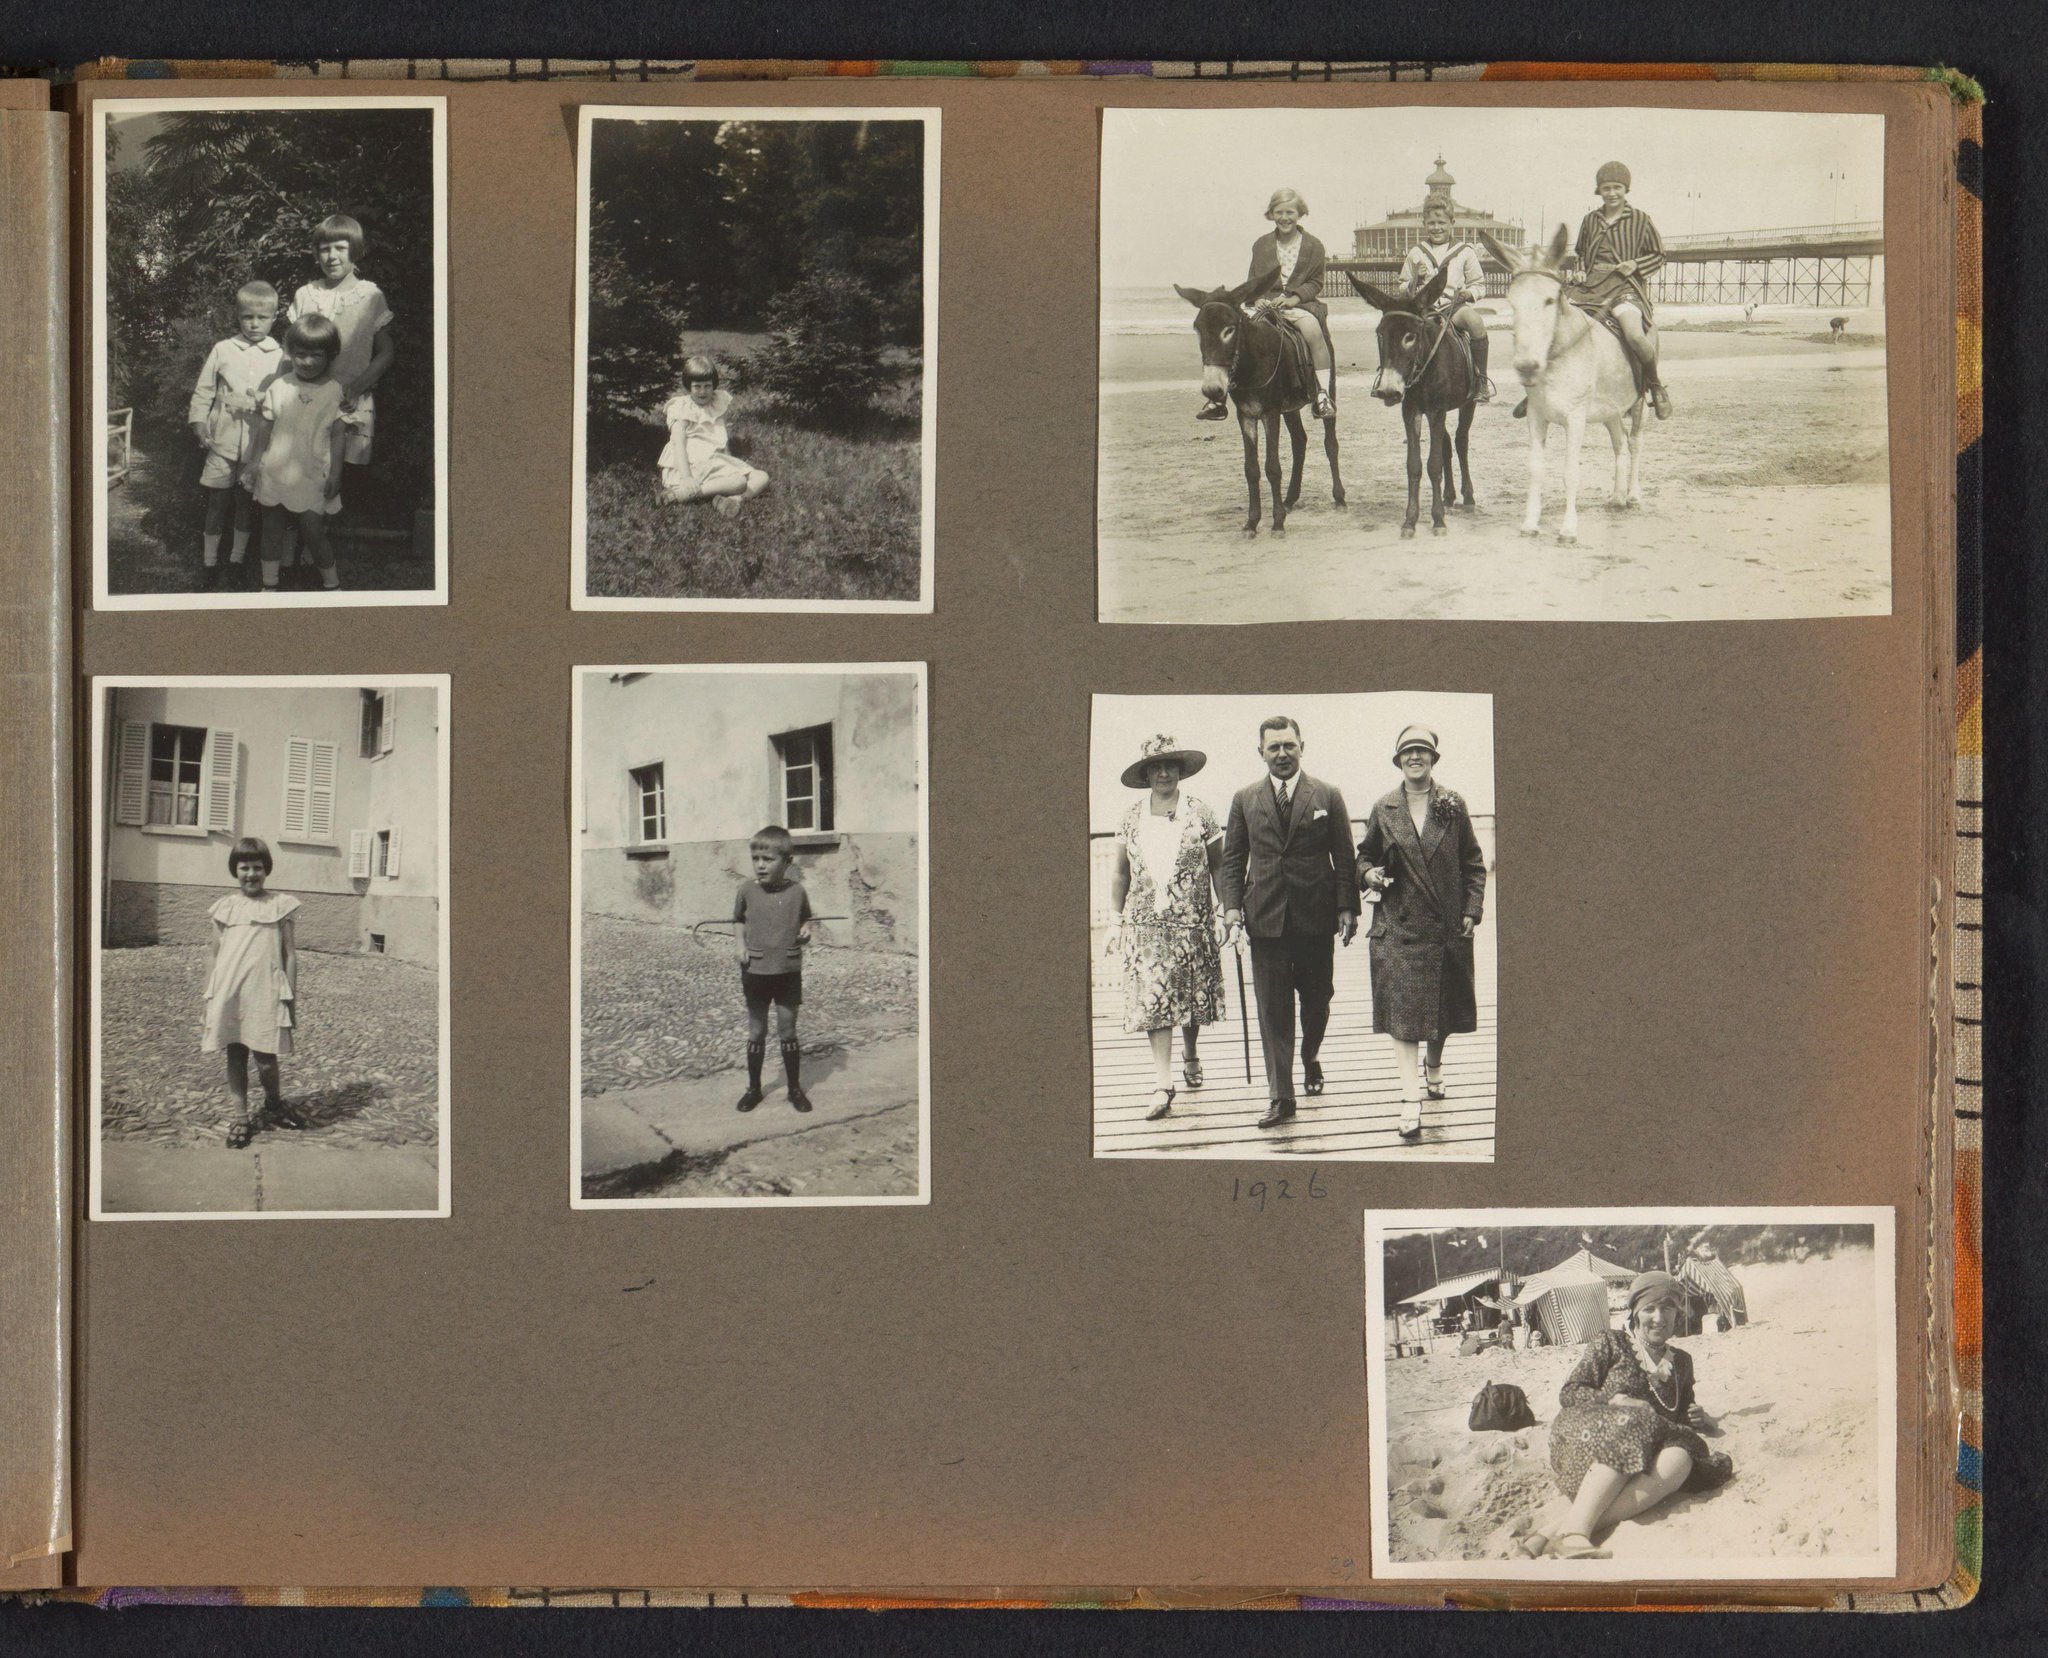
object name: album leaf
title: Portretten van volwassenen en kinderen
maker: Anonymous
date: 1900-1926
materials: cardboard, photographic support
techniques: gelatin silver print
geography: scheveningen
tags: riding a horse, ass, or mule; rider, horseman, adult woman, adult man, child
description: Albumblad met foto's van volwassen en kinderen, onder meer op ezels aan het strand van Scheveningen ('Ezeltje rijden langs het strand'). Onderdeel van Fotoalbum van een onbekende Nederlandse familie met connecties in Suriname en Nederlands-Indië (2).